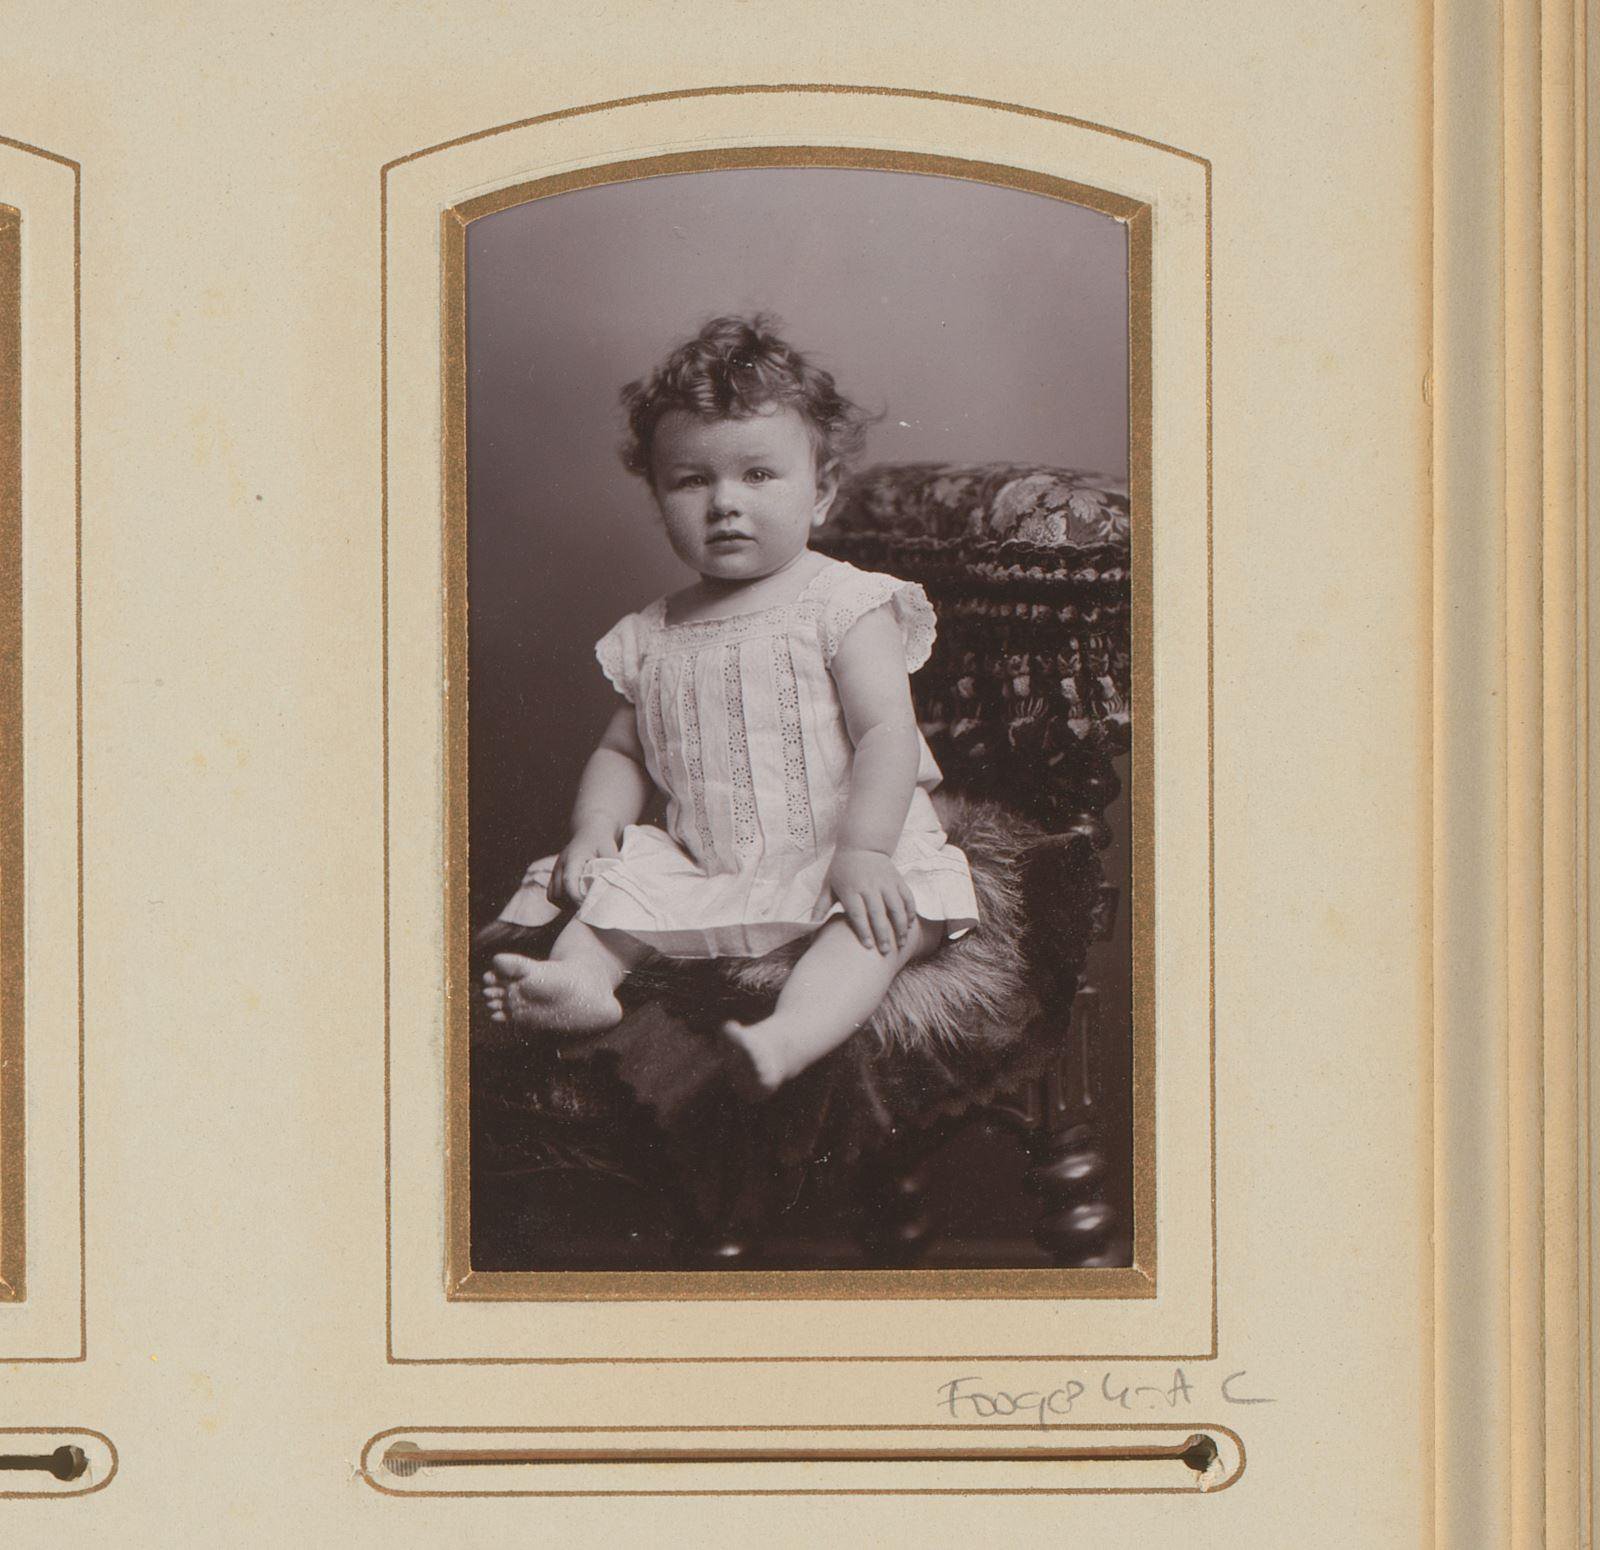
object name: album leaf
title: Portret van een zittend meisje in witte kanten jurk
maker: b.j. pottjewijd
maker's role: fotograaf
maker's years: 1859-1941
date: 1880-1920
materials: cardboard, photographic support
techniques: collodion silver print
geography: winschoten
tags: sitting figure - aa - female human figure, historical persons - bb - woman, toddler (female)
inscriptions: inscription: ‘B. J. Pottjewijd/ Winschoten/ Het negatief blÿft voor nabestelling bewaard./ Vergrootingen in alle afmetingen.’